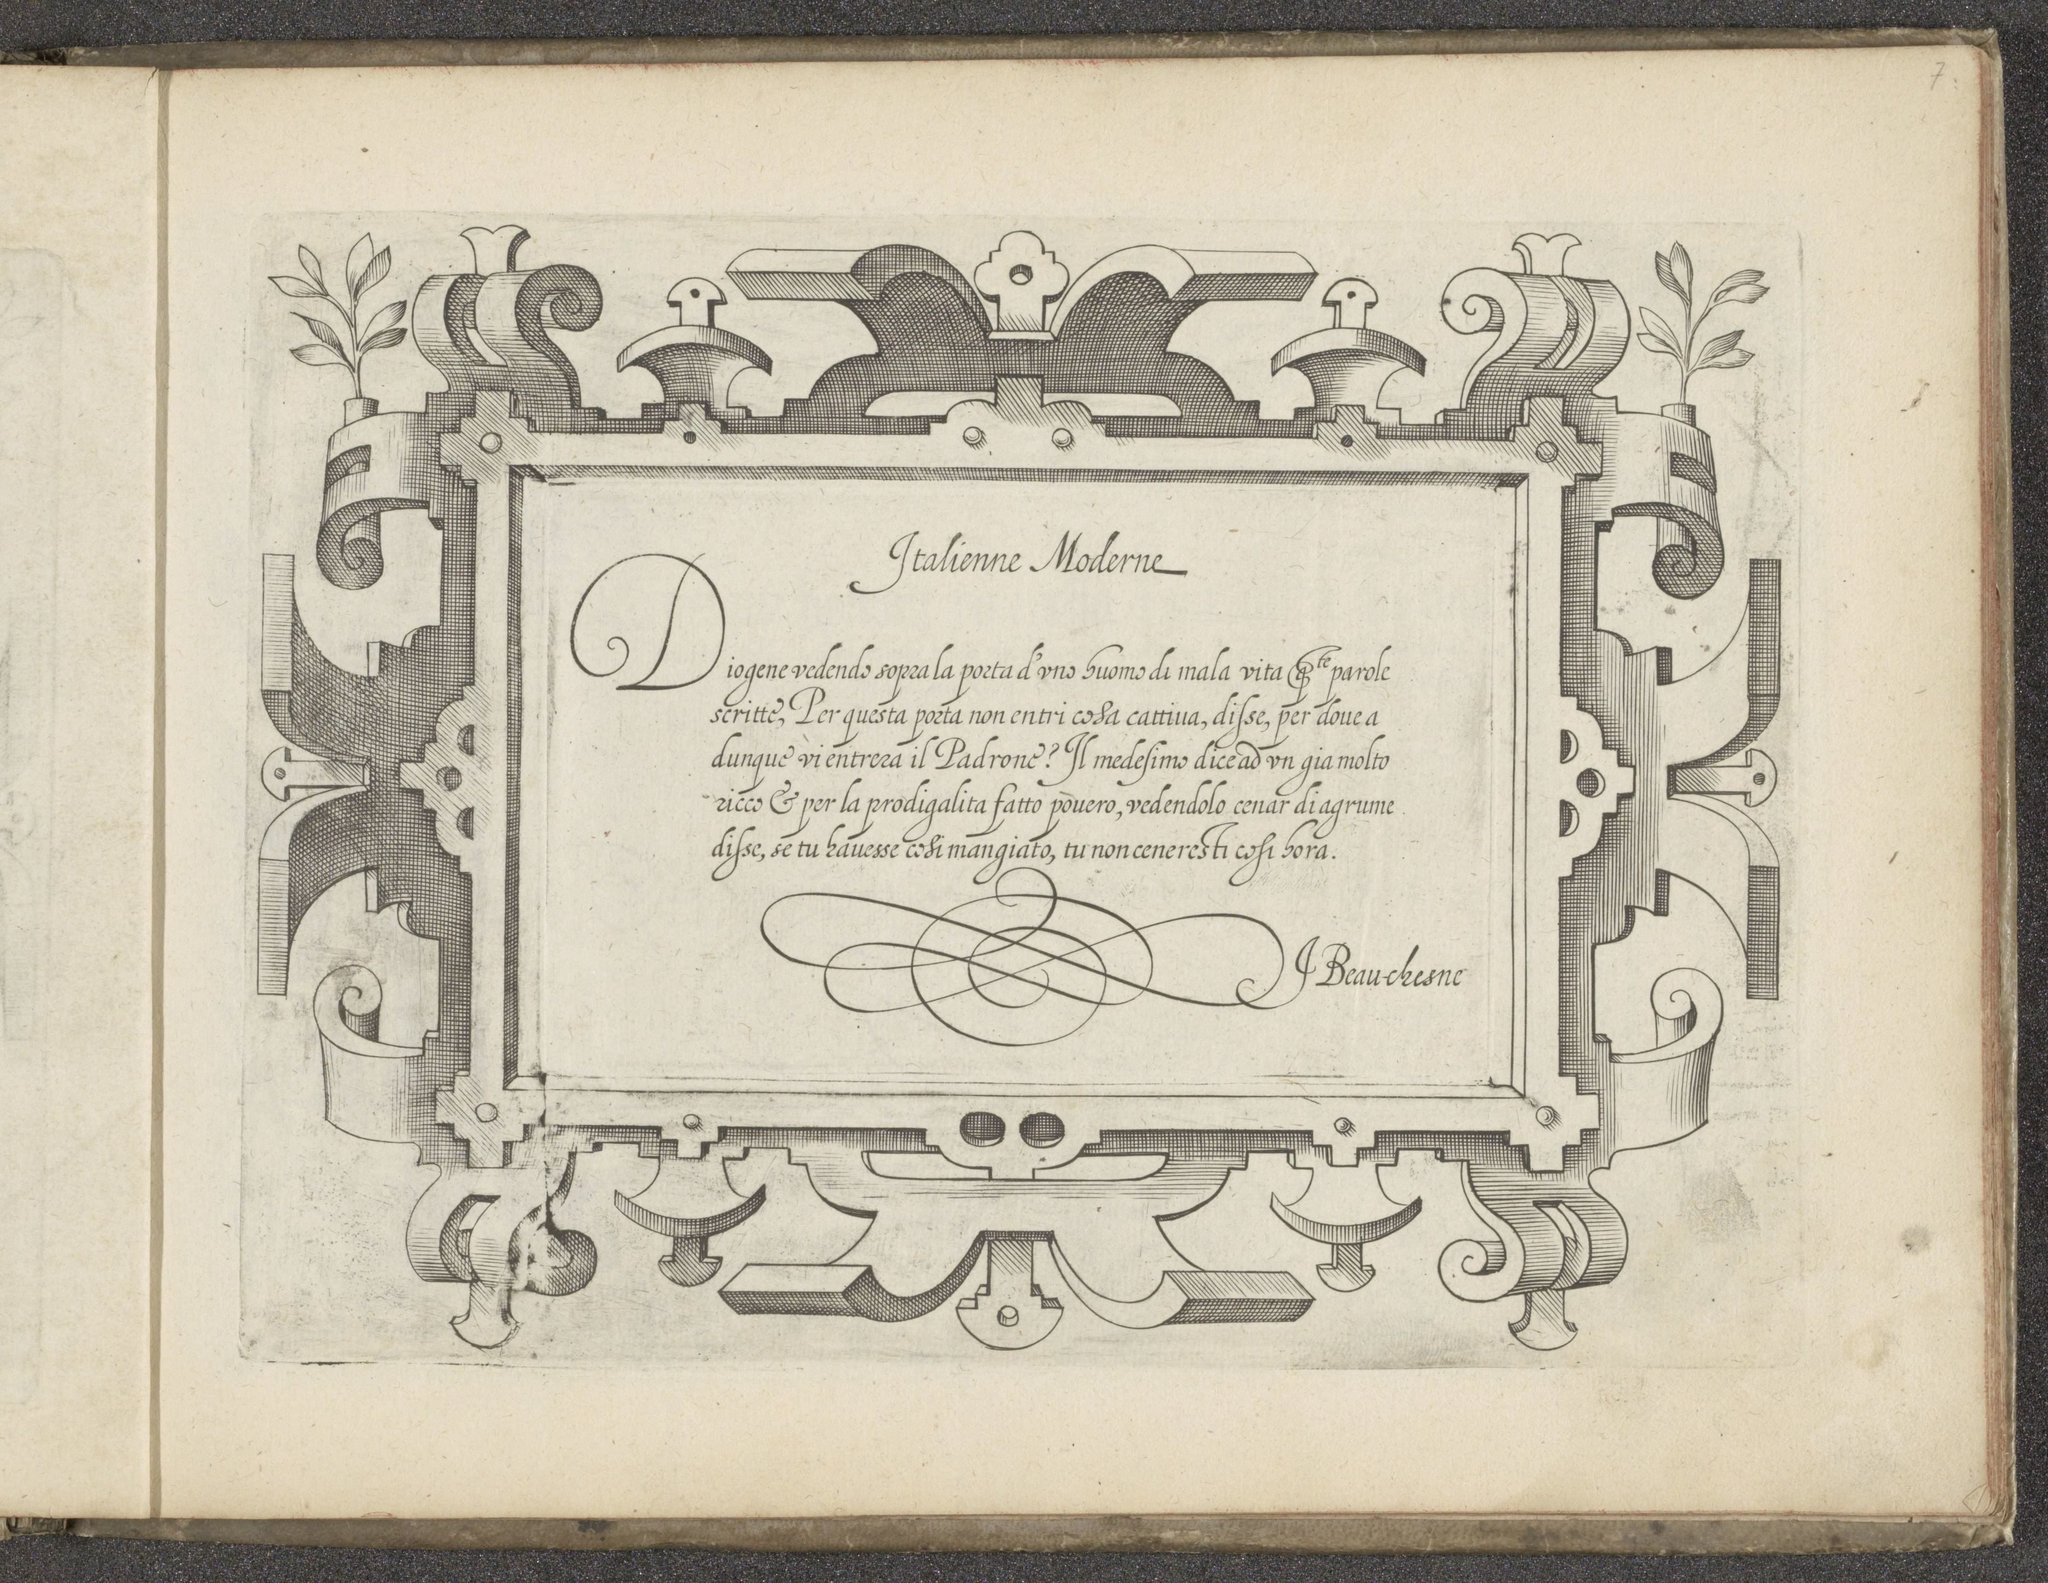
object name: album leaf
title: Schrijfvoorbeeld: Diogene vedendo sopra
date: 1614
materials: paper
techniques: engraving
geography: amsterdam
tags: scrollwork, strapwork ~ ornament, ornament ~ cartouche, calligraphy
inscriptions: signature and date: ‘Op titelblad: Judoco Hondio celatore. Amstelodami apud Joannem Janssonium. 1614’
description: Schrijfvoorbeeld in een humanistische hand met een titel en vijf regels tekst in het Italiaans. Het voorbeeld is gevat in een rolwerkcartouche. De prent maakt deel uit van een album.